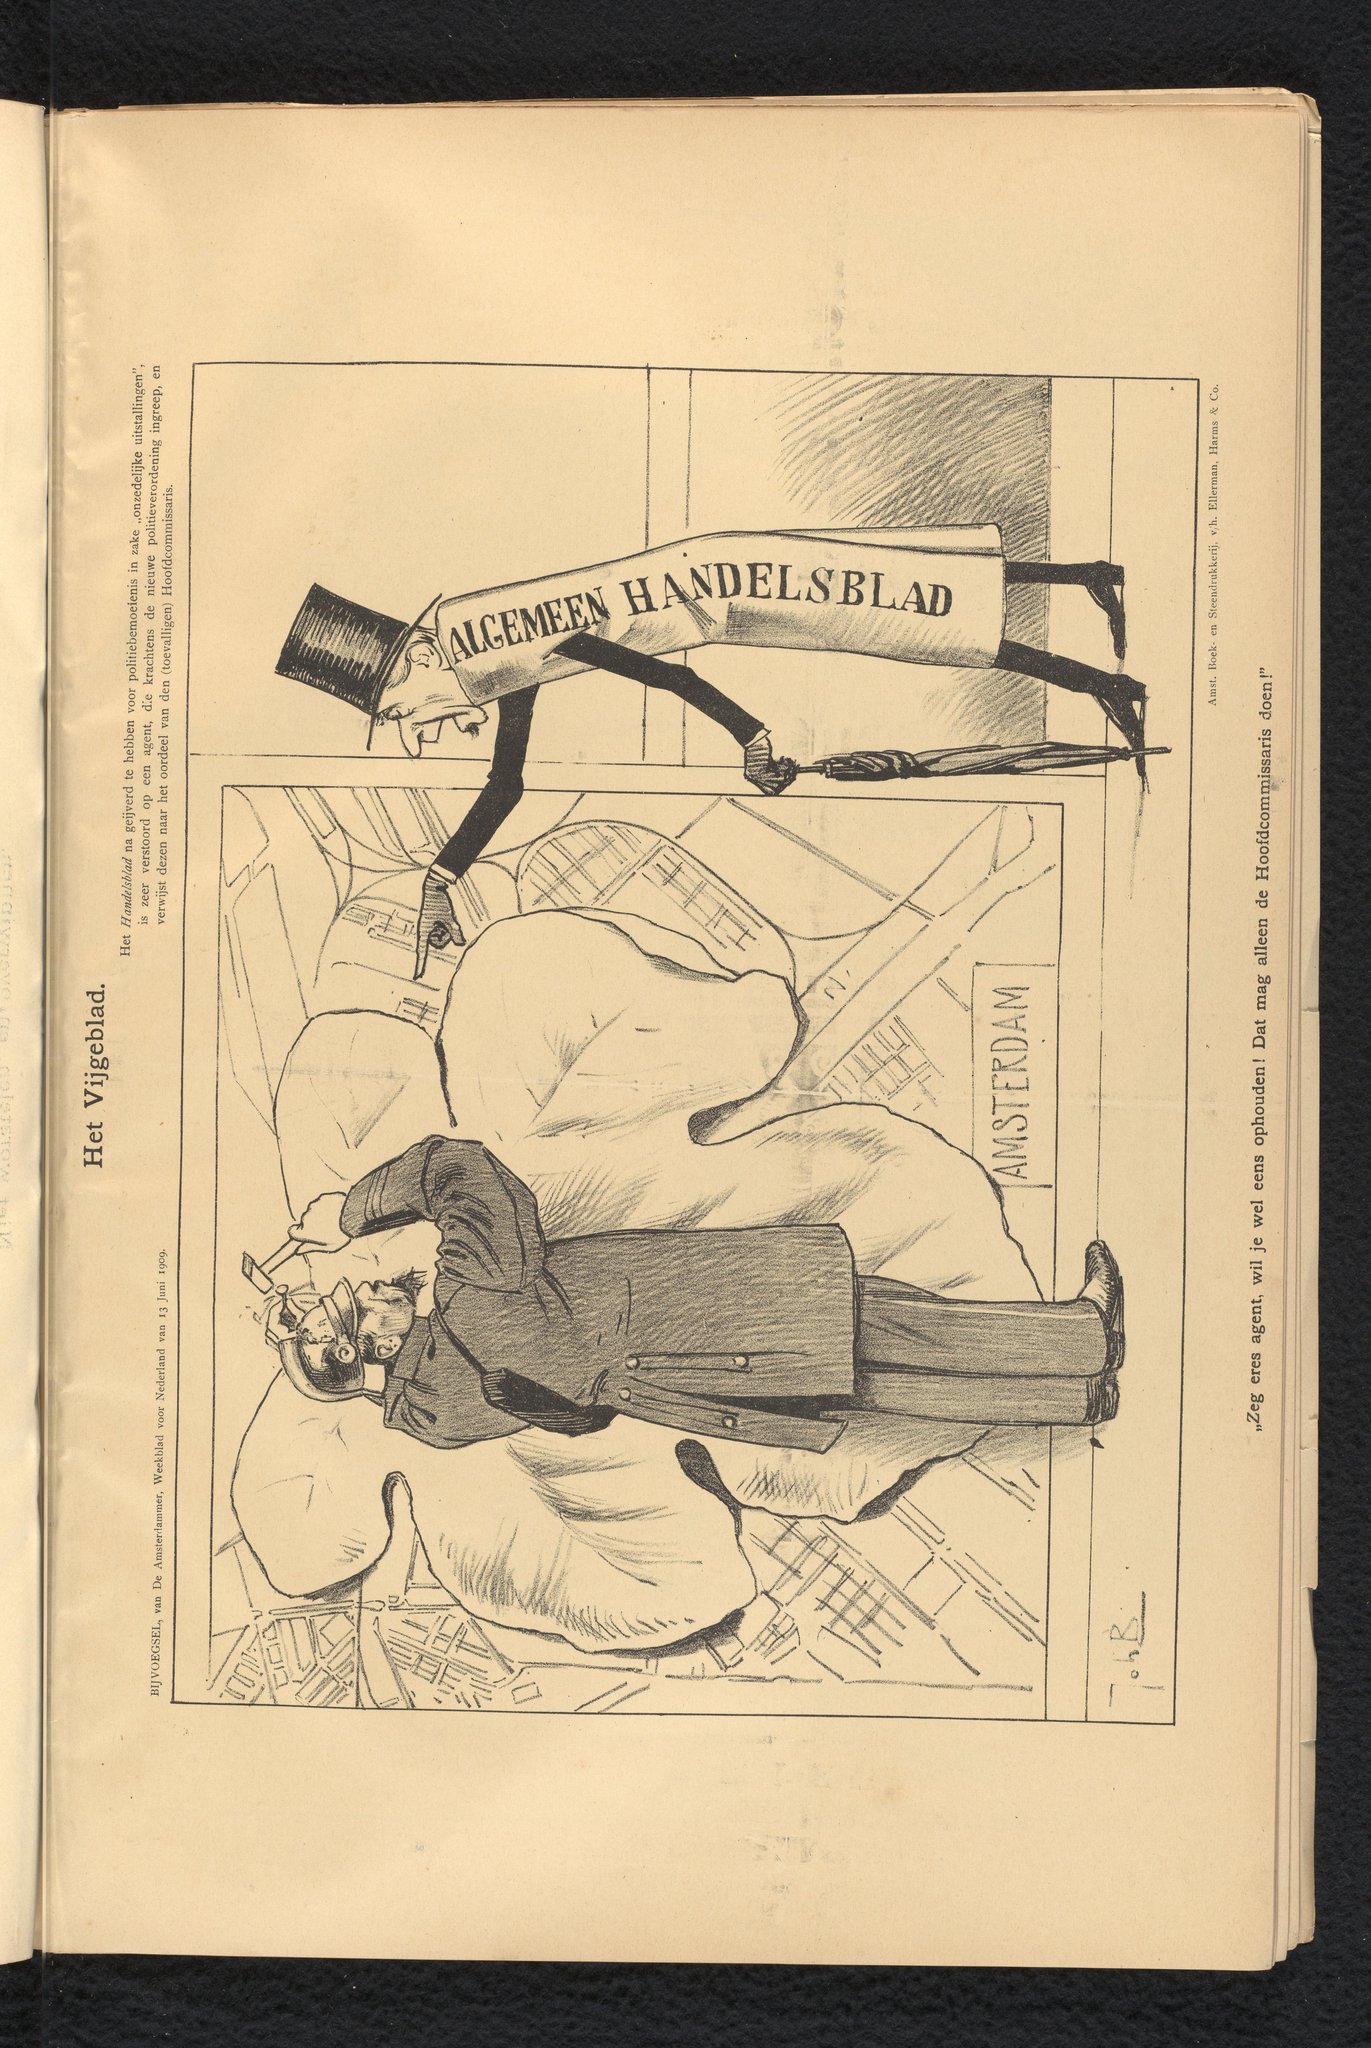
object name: cartoon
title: Het Vijgeblad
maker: johan braakensiek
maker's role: draughtsman, print maker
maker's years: 1858-1940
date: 1909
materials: paper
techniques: lithograph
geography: amsterdam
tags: personifications of countries, nations, states, districts, etc., trees: fig-tree (leaves, putting forth leaves), policeman, constable, newspaper, news-sheet, maps of cities, political caricatures and satires, amsterdam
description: Het Algemeen Handelsblad spreekt een politieagent aan die een vijgenblad vasttimmert over een plattegrond van Amsterdam.